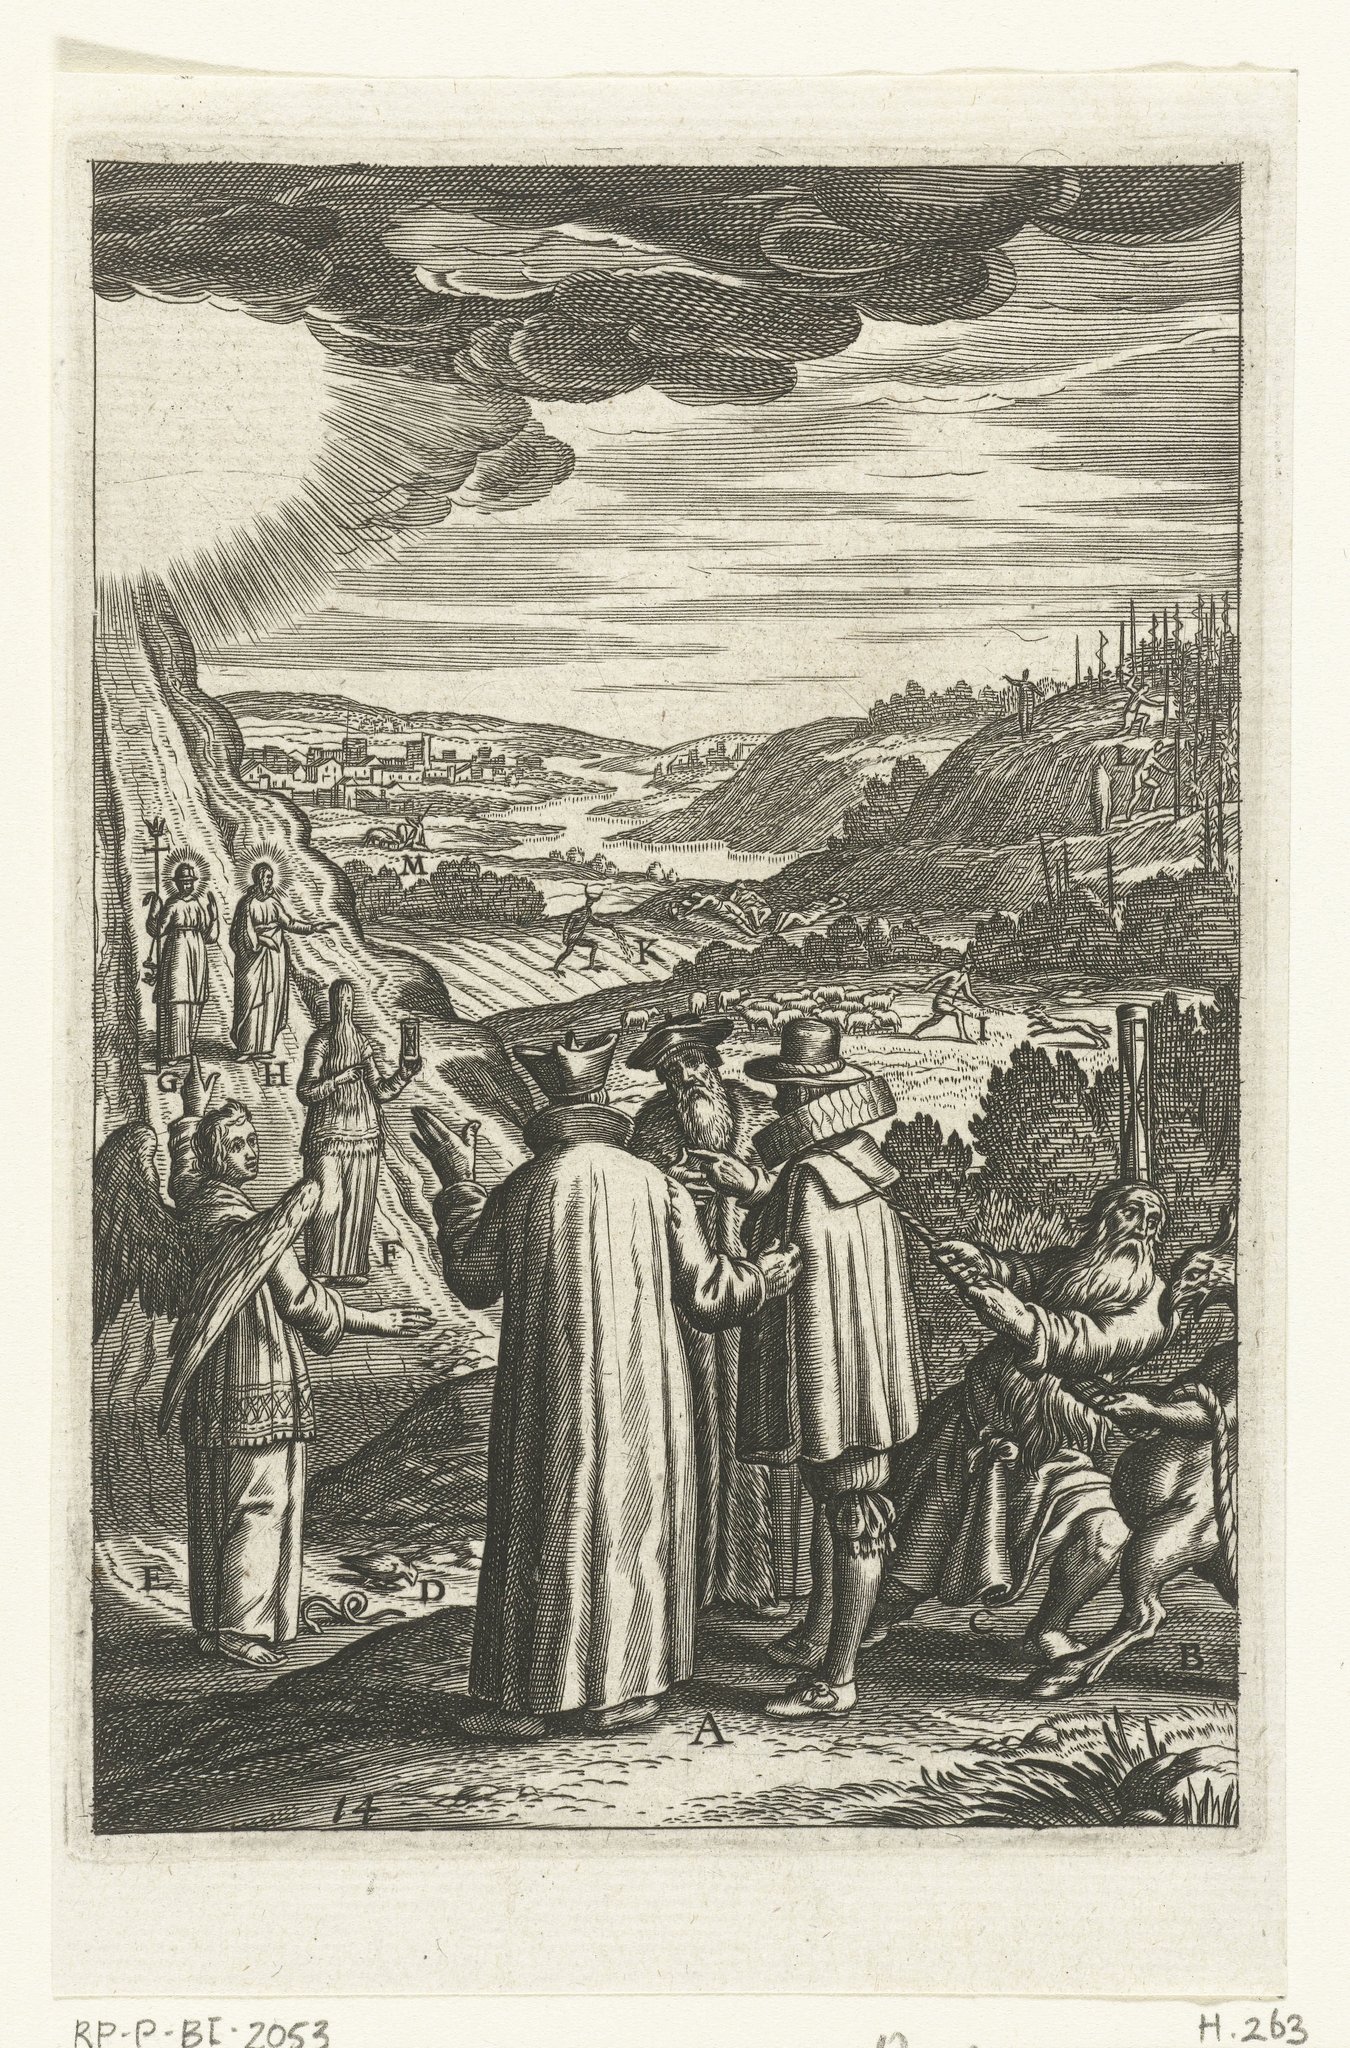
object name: book illustration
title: Embleem met man die zijn vrienden aanraadt te leven in deugd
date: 1620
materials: paper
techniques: engraving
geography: antwerp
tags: the life of man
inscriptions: collector's mark: Lugt 2228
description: Een man raadt zijn vrienden aan om in deugd te leven. De duivel en een goddeloze trekken aan een steeds dikker wordend koord dat staat voor de verleiding van een leven in zonde waarmee de man moet breken. Een engel wijst de goede weg naar het eeuwige leven. In het landschap zijn onder andere de parabelen van de herder en de zaaier weergegeven.